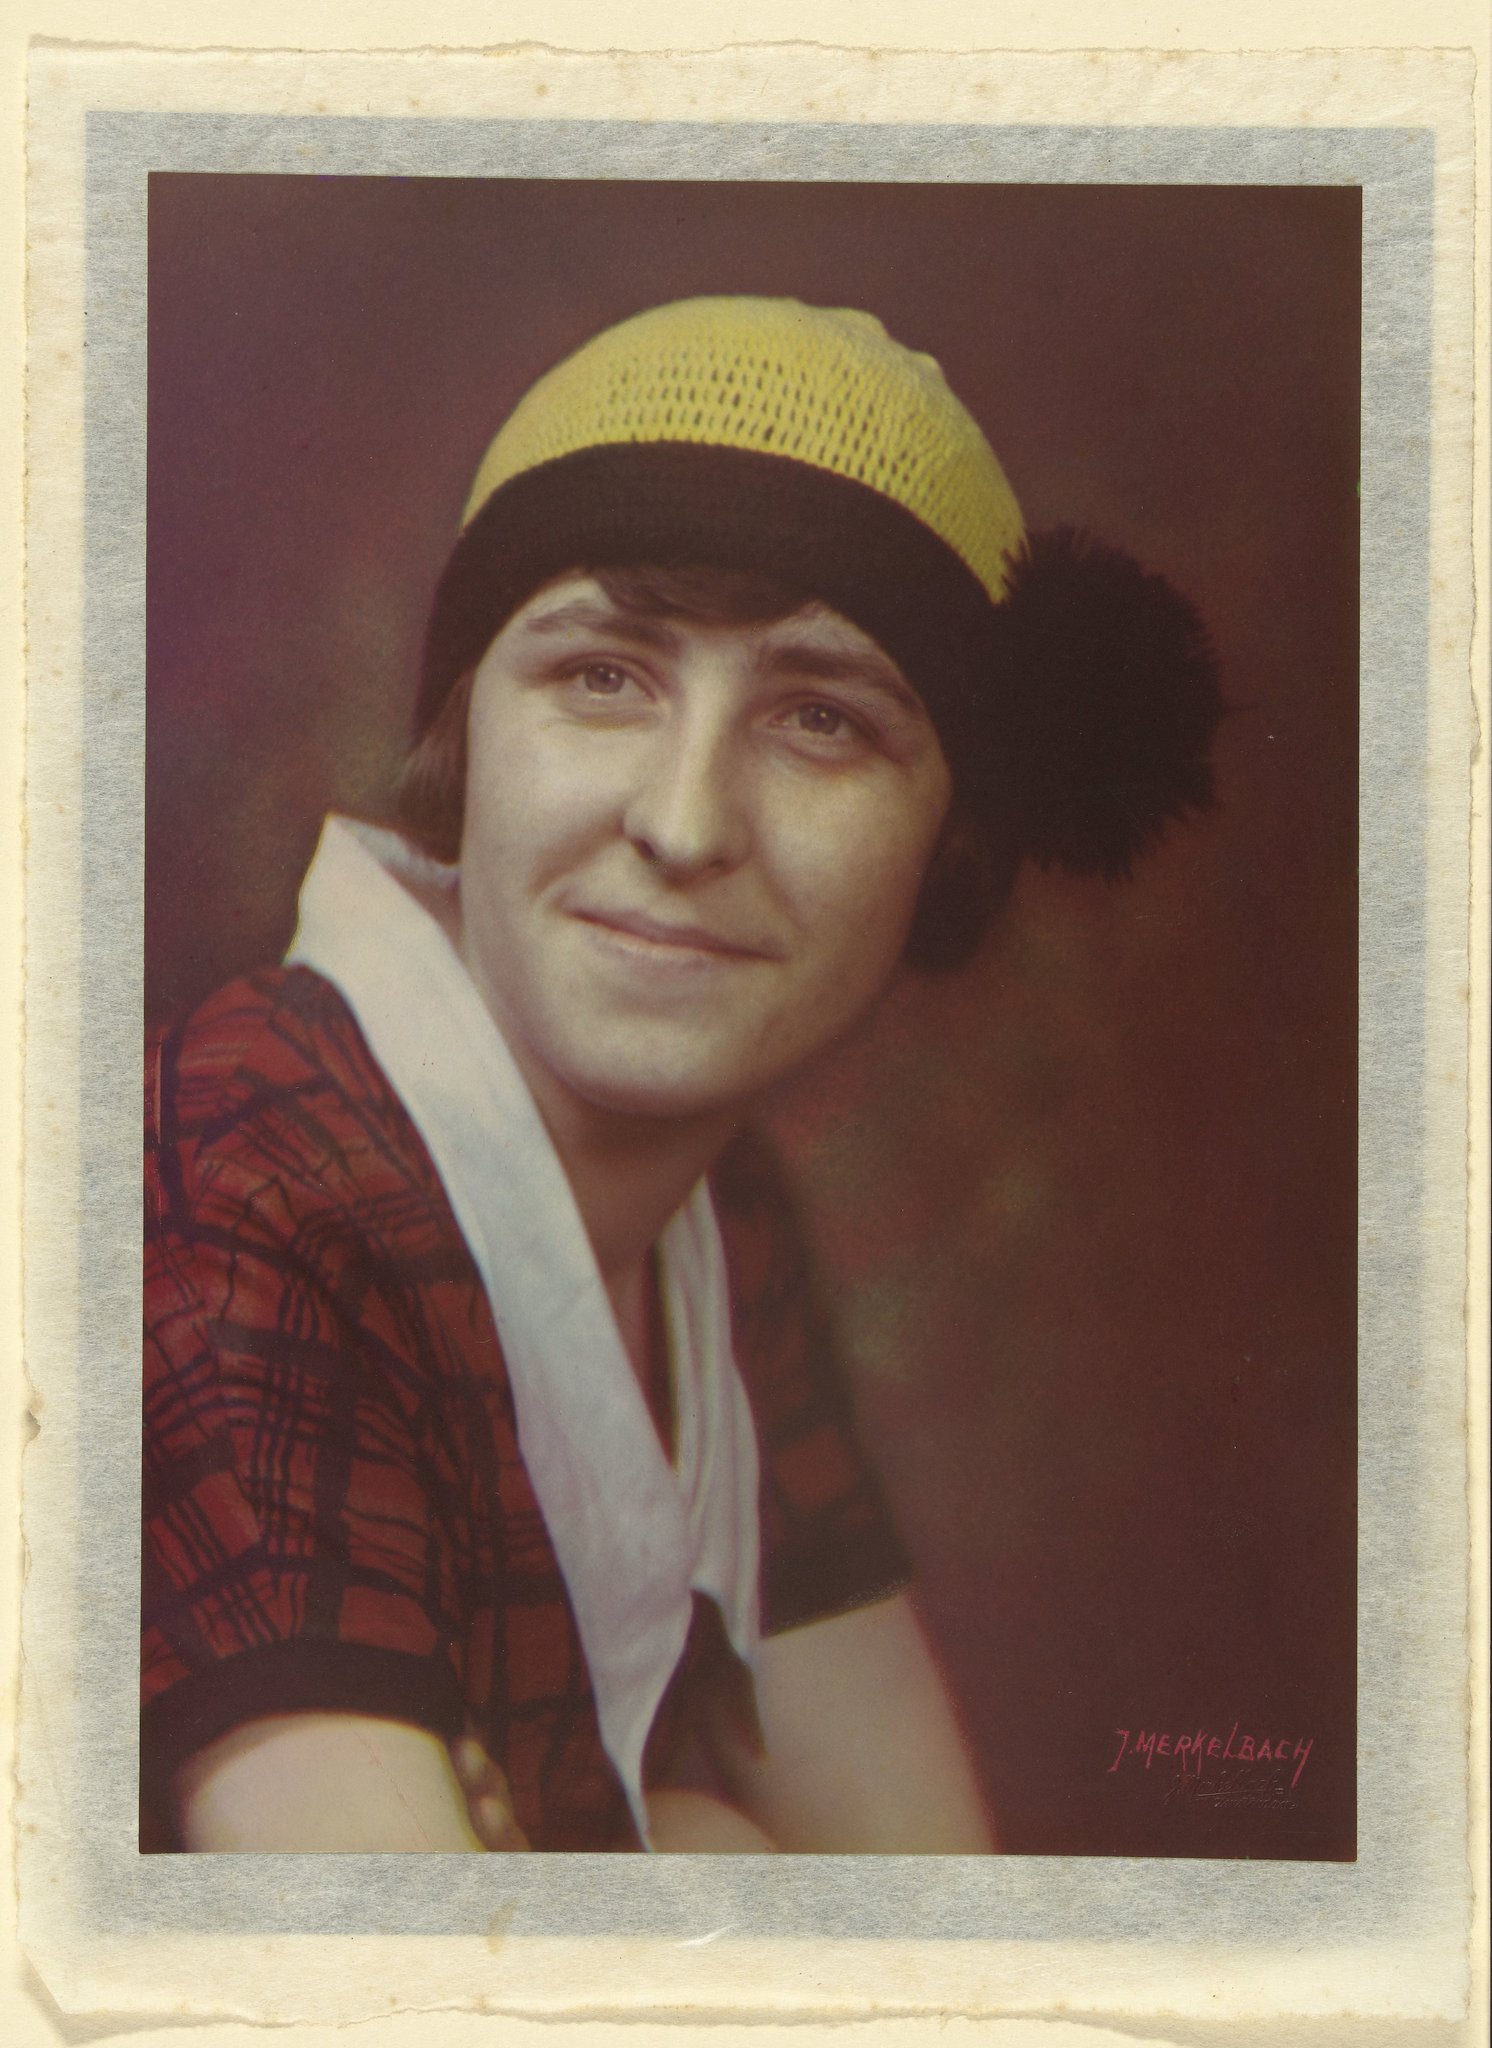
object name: photograph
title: Portret van Mies Rosenboom-Merkelbach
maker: jacob merkelbach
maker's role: fotograaf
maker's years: 1877-1942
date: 1920-1930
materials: cardboard, paper, photographic support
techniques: jos-pé print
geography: amsterdam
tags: historical persons (portraits and scenes from the life) - bb - woman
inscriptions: annotation: ‘Mies Rosenboom-Merkelbach. Jos-Pe druk.’